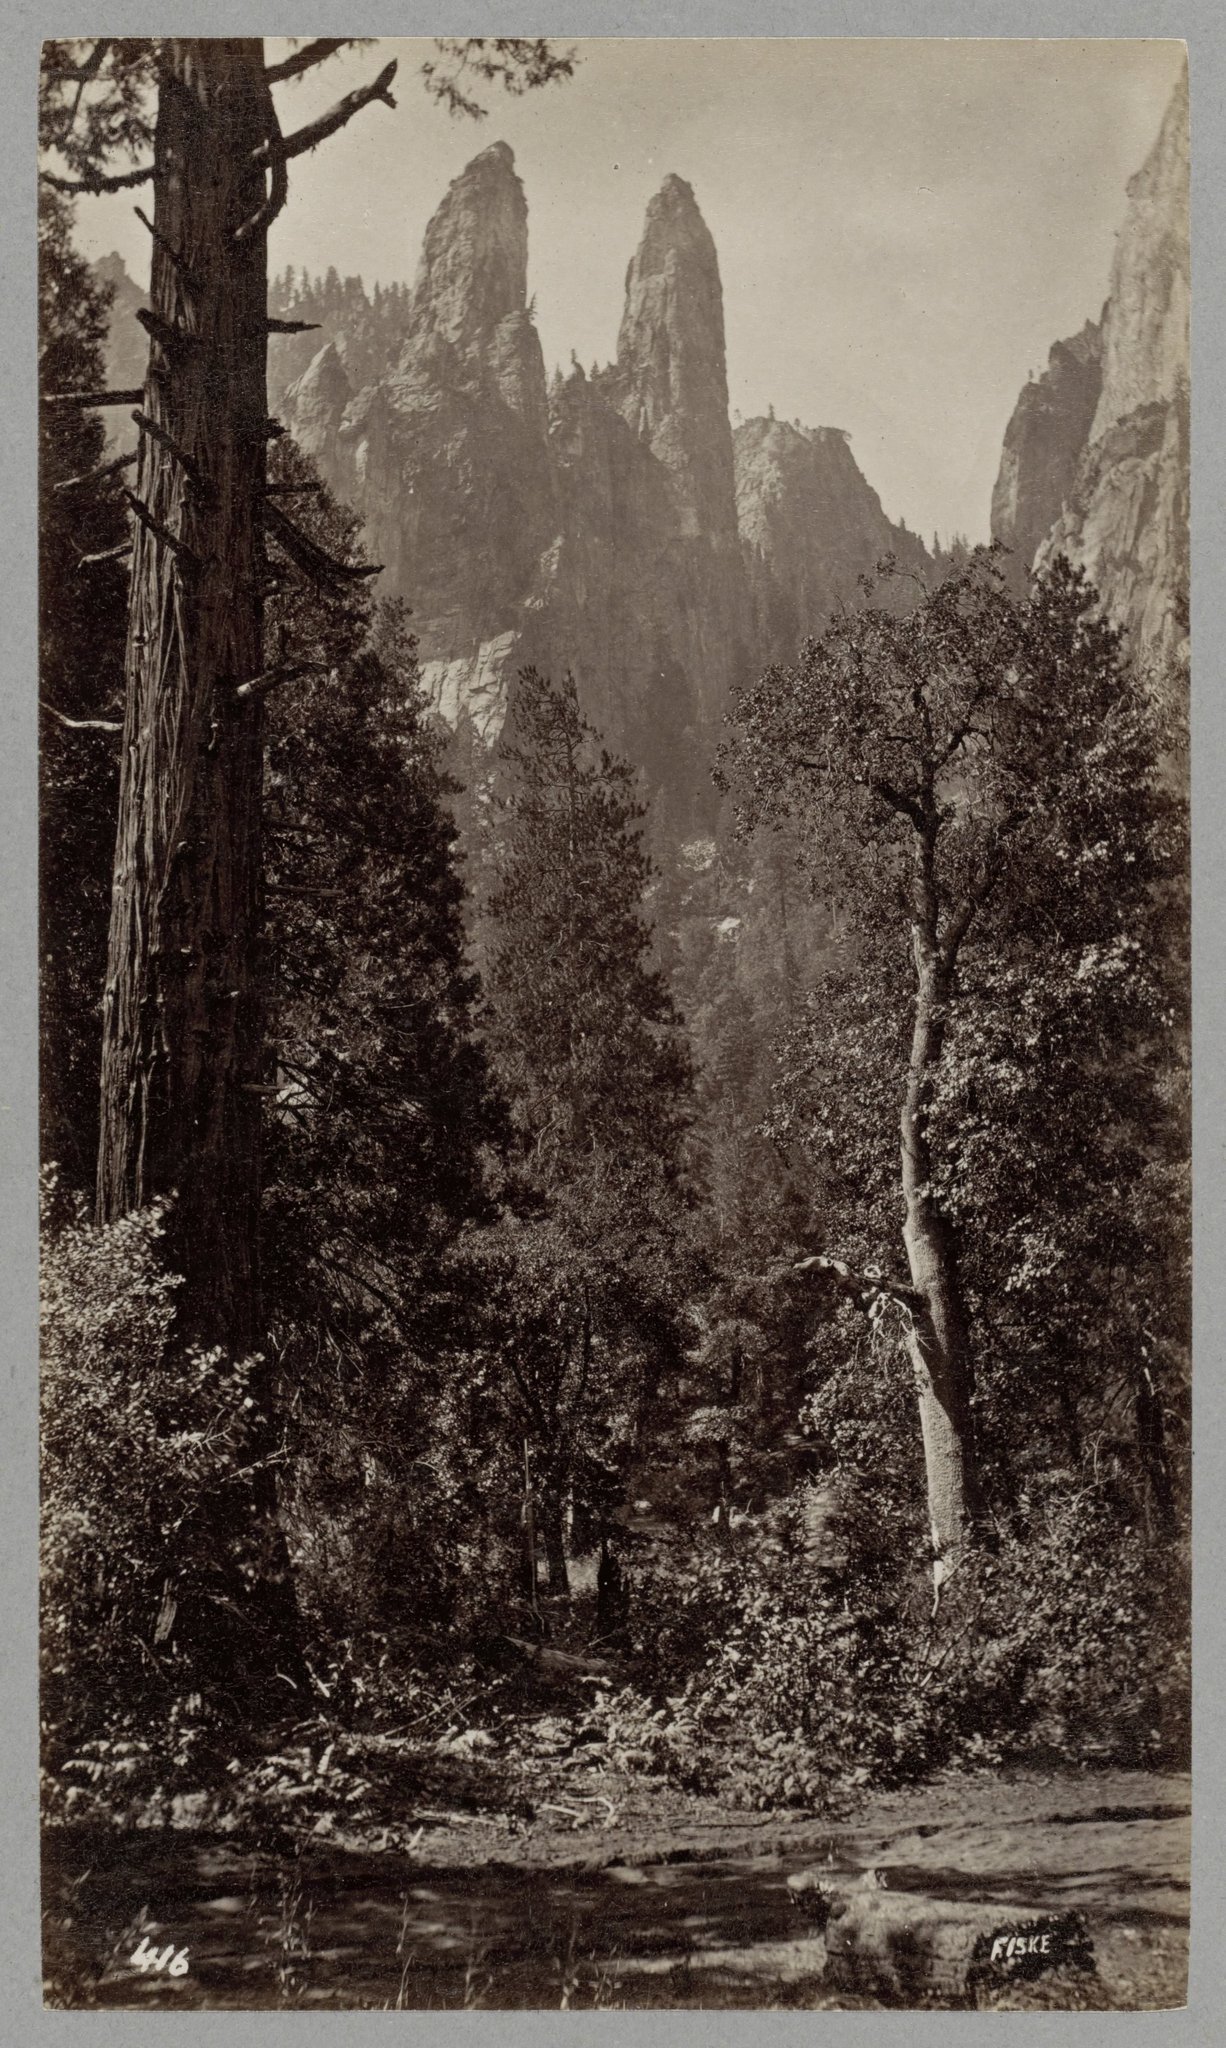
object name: photograph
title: Kloof met rotsformatie in de Verenigde Staten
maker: george fiske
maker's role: fotograaf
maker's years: 1835-1918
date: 1880-1900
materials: cardboard, paper, photographic support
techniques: albumen print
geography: united states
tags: rock-formations, united states of america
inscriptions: negative number: ‘416’